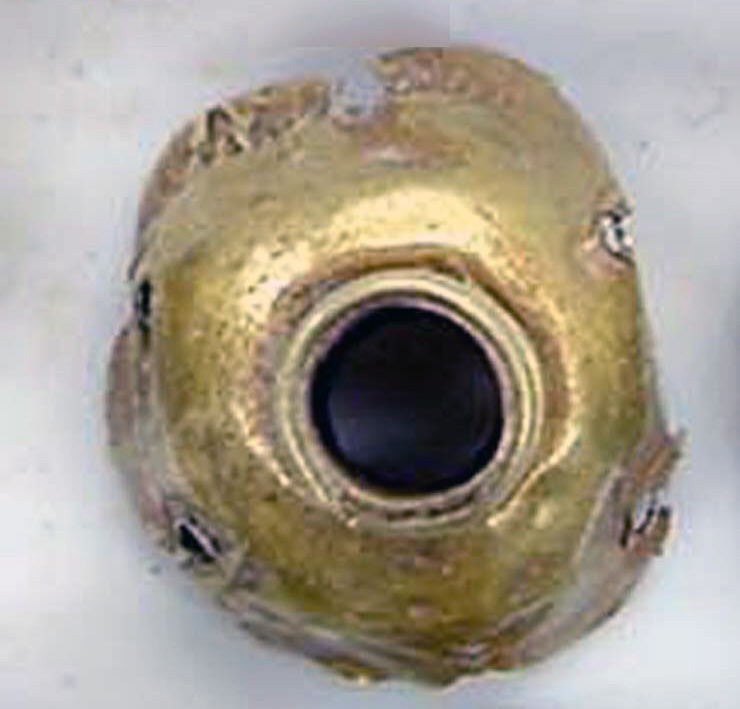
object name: plaque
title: Flower-Shaped Plaque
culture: northwest chinese or eastern central asian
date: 634-900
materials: gold